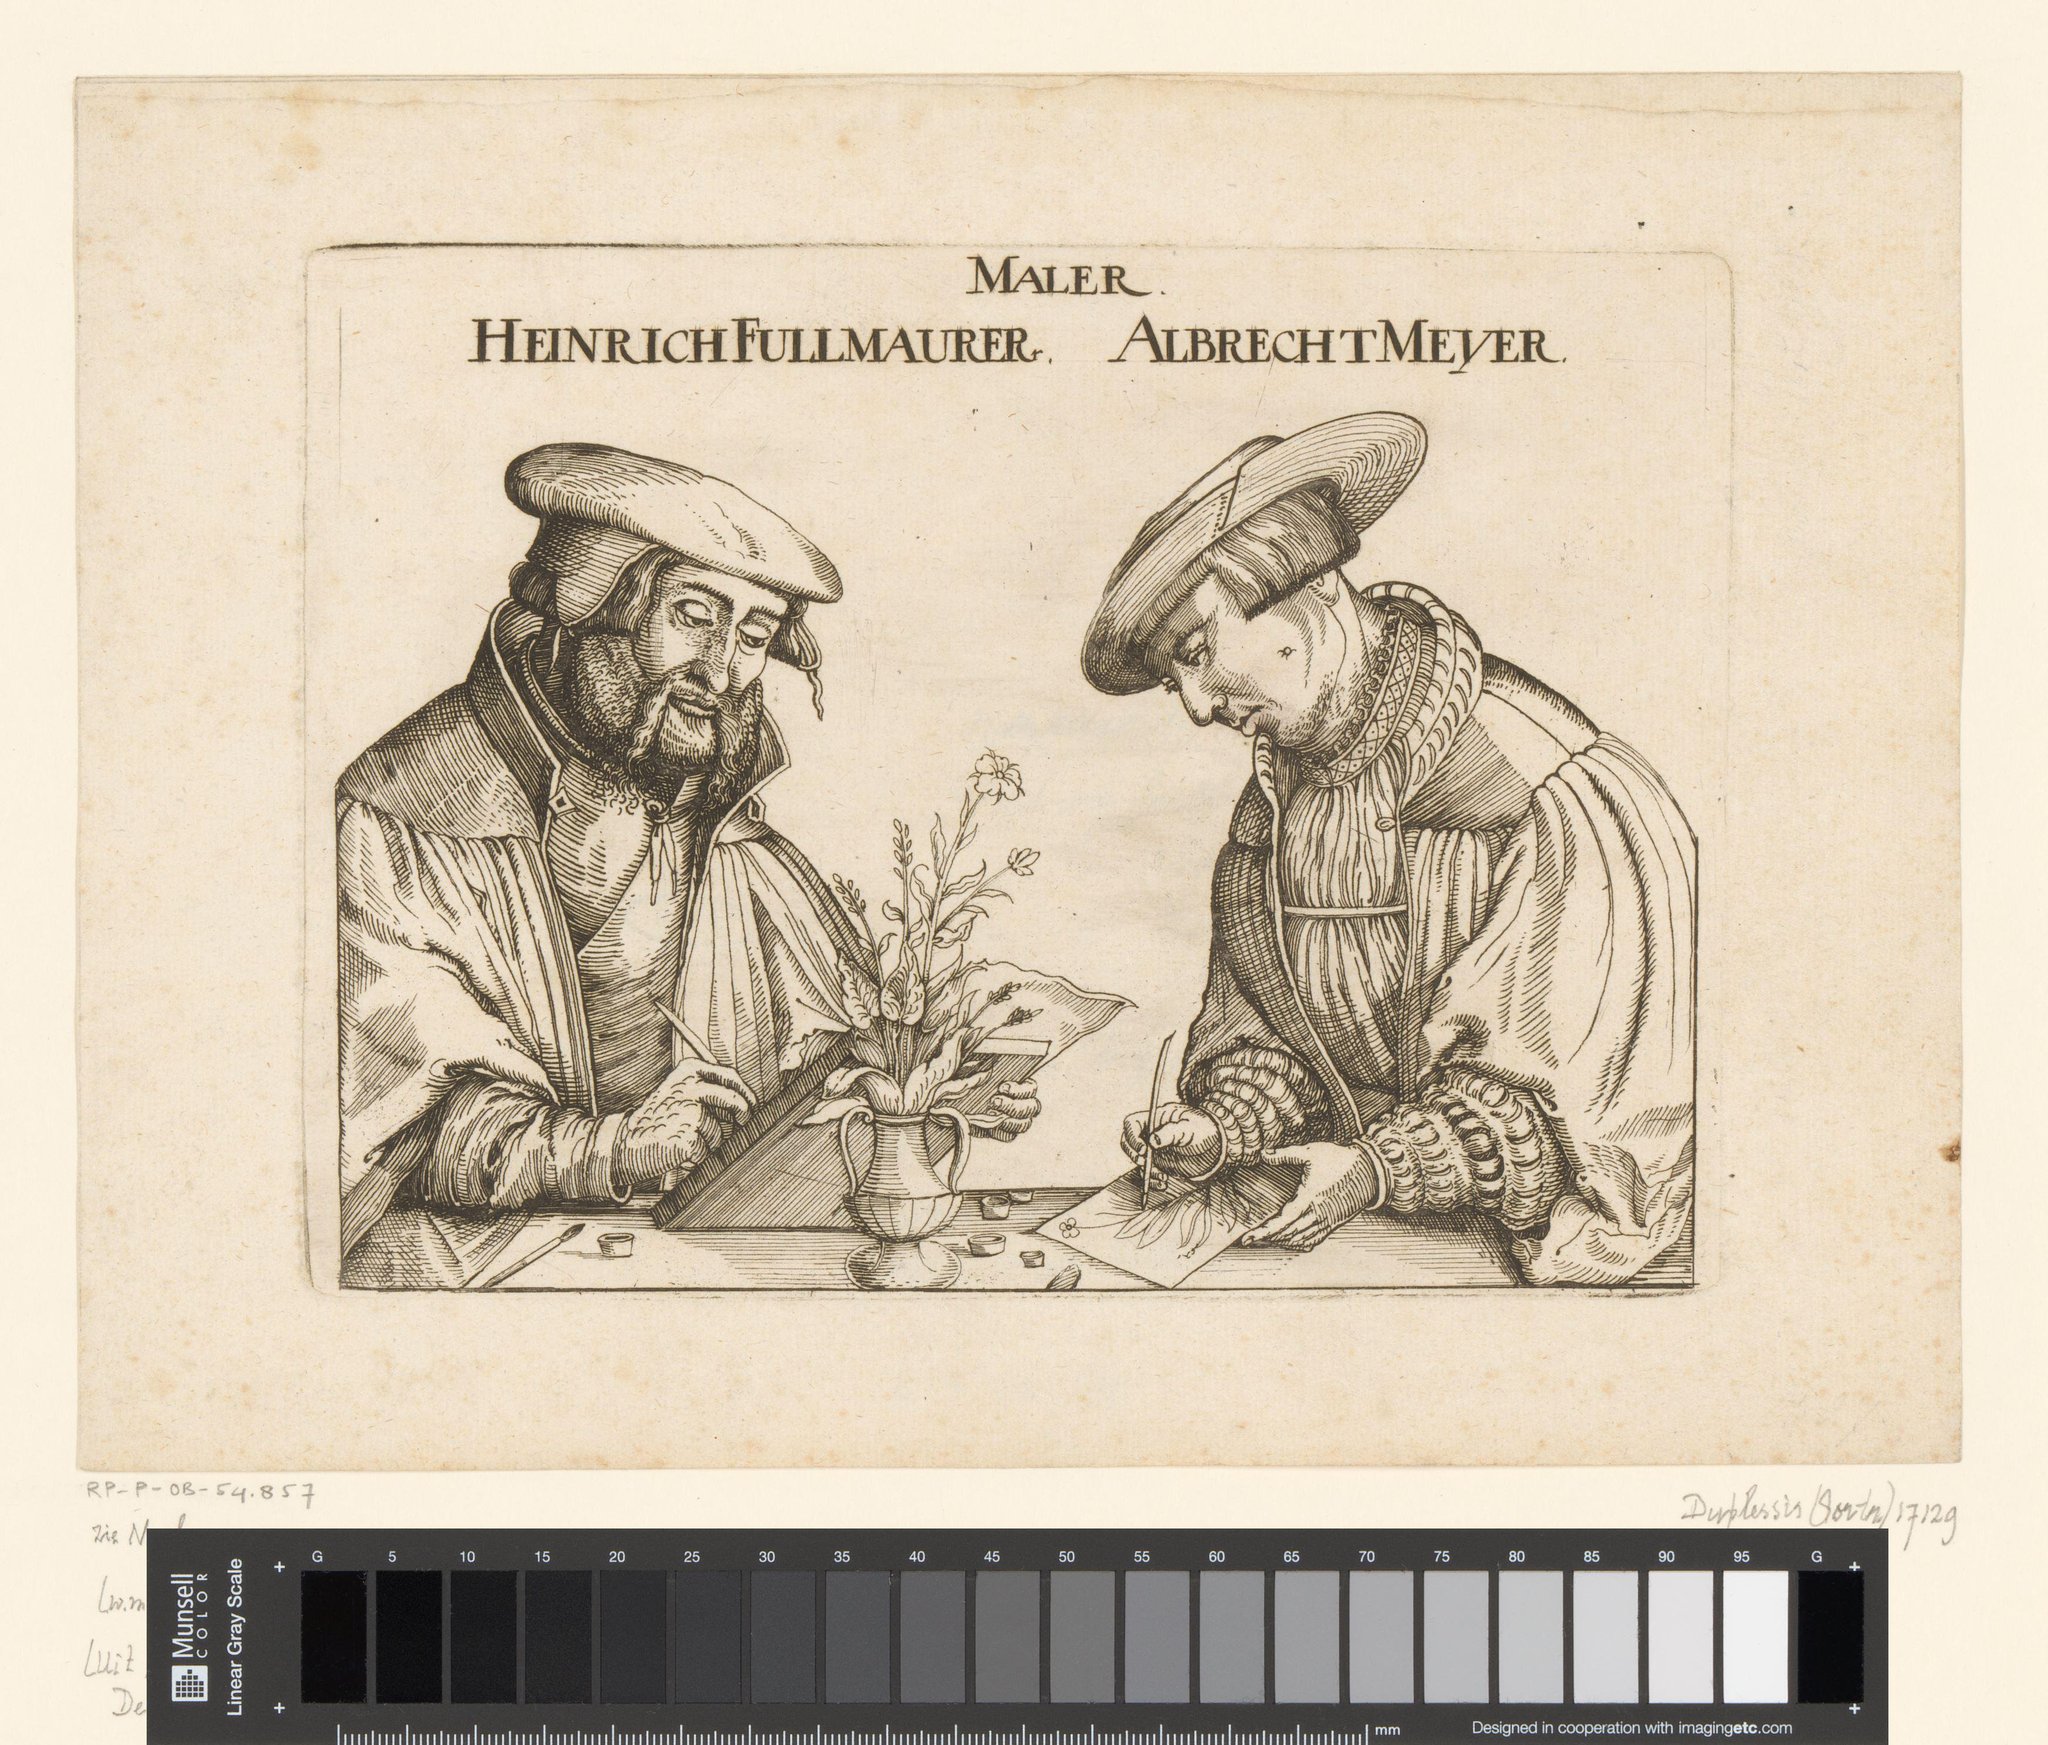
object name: print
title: Dubbelportret van Heinrich Füllmaurer en Albrecht Meyer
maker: Anonymous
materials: paper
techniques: etching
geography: basel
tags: draughtsman, painter, woodcutter, wood-engraver, draughtsman at work, flowers in a vase, portrait, self-portrait of graphic artist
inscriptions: collector's mark: Lugt 2228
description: Albrecht Meyer draagt een platte hoed met ronde rand, Fullmaurer een bonnet met oorkleppen en een rechtgesneden rand van achteren. Beiden dragen een tabbaard met opstaande kraag.